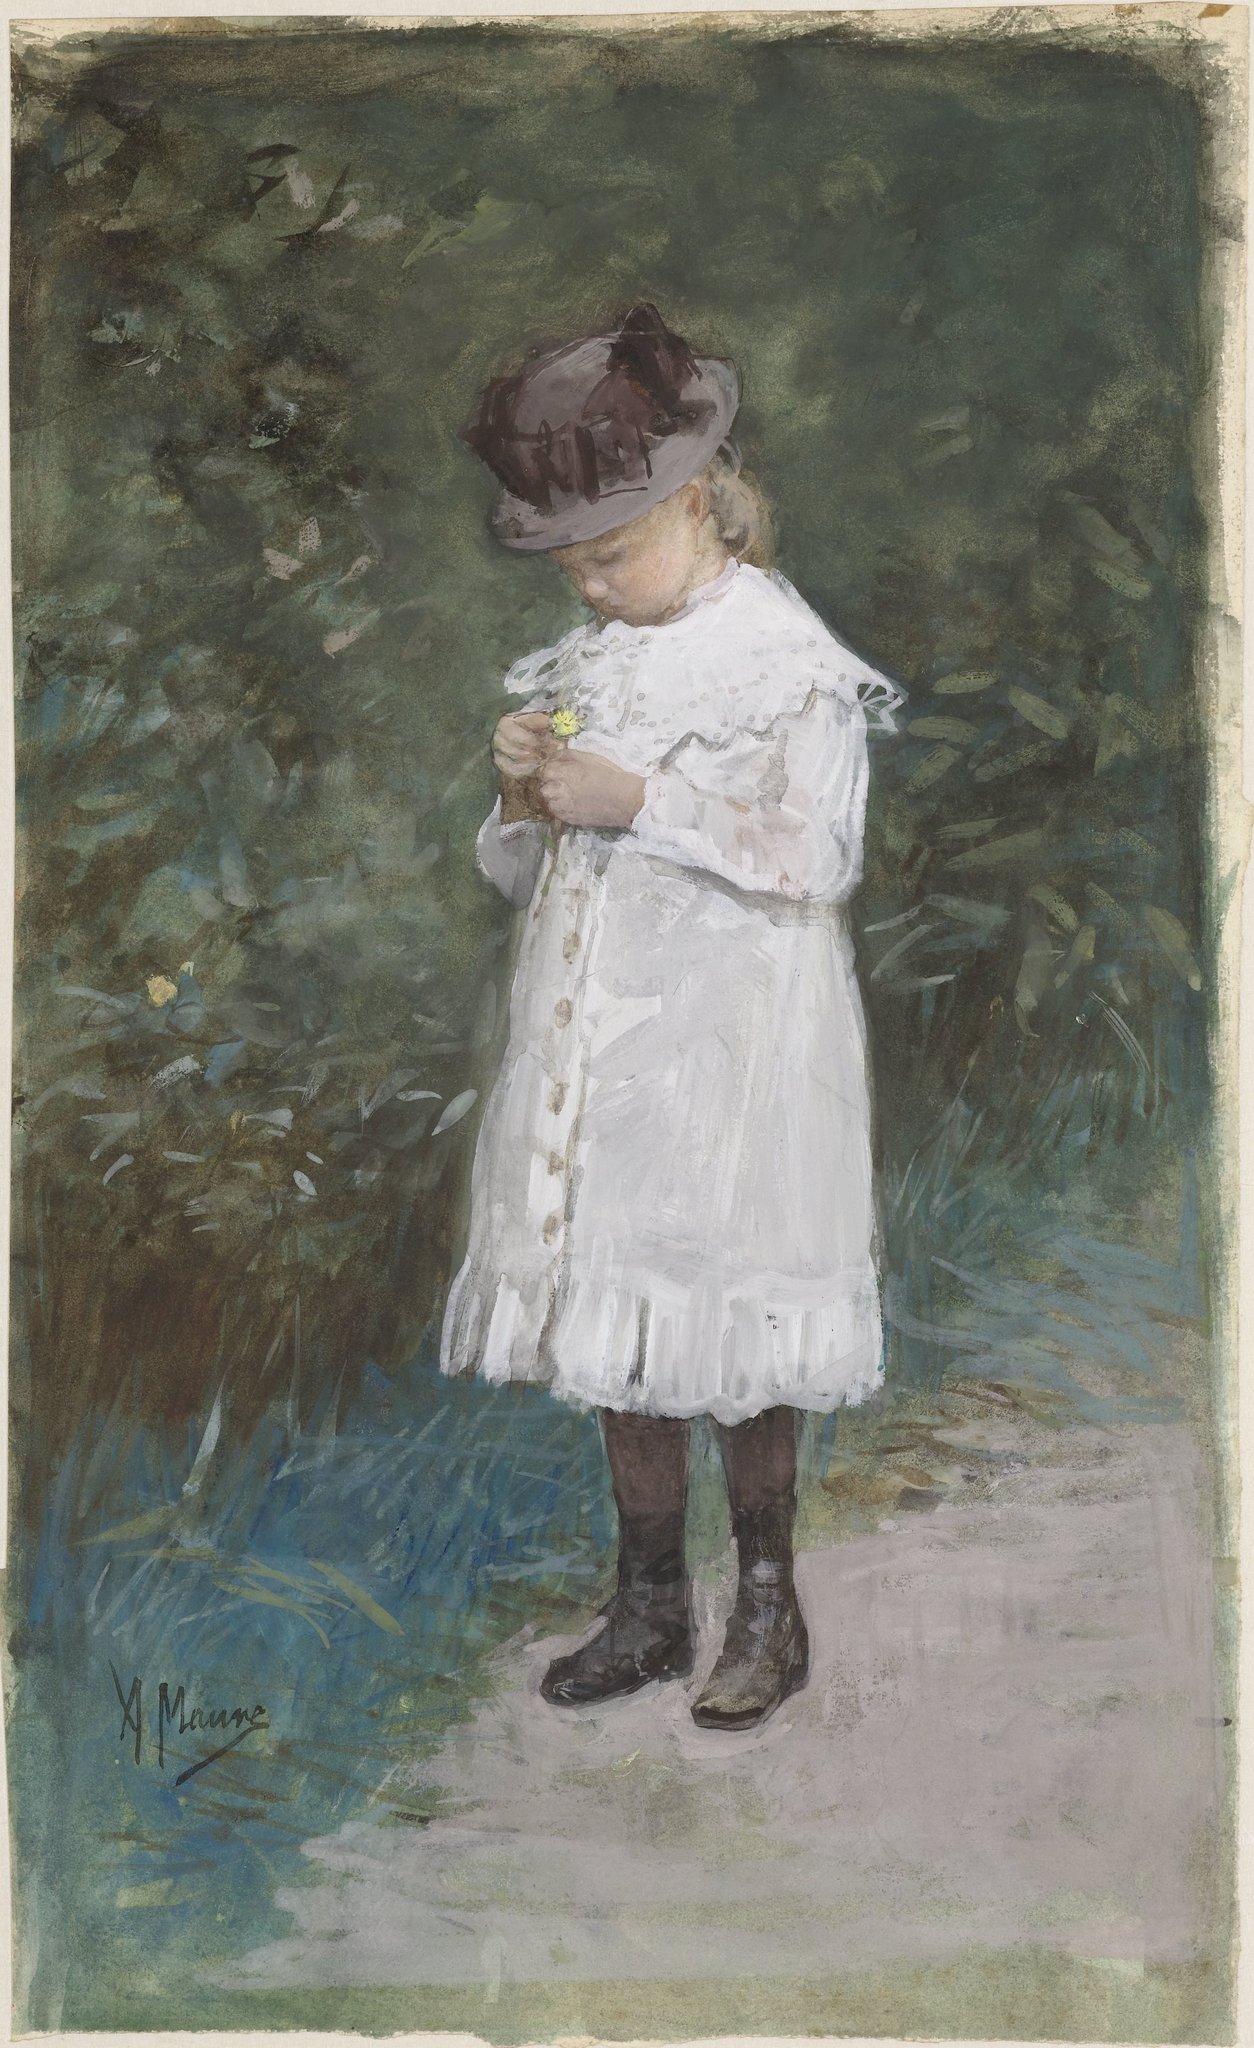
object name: drawing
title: Elisabeth Mauve (b. 1875), Daughter of the Artist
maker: anton mauve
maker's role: draughtsman, painter, print maker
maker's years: 1838-1888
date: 1875-1888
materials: paper, watercolor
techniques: brush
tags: historical persons - bb - woman, girl (child between toddler and youth)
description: Elisabeth Mauve, dochtertje van de kunstenaar, staande op een tuinpad.